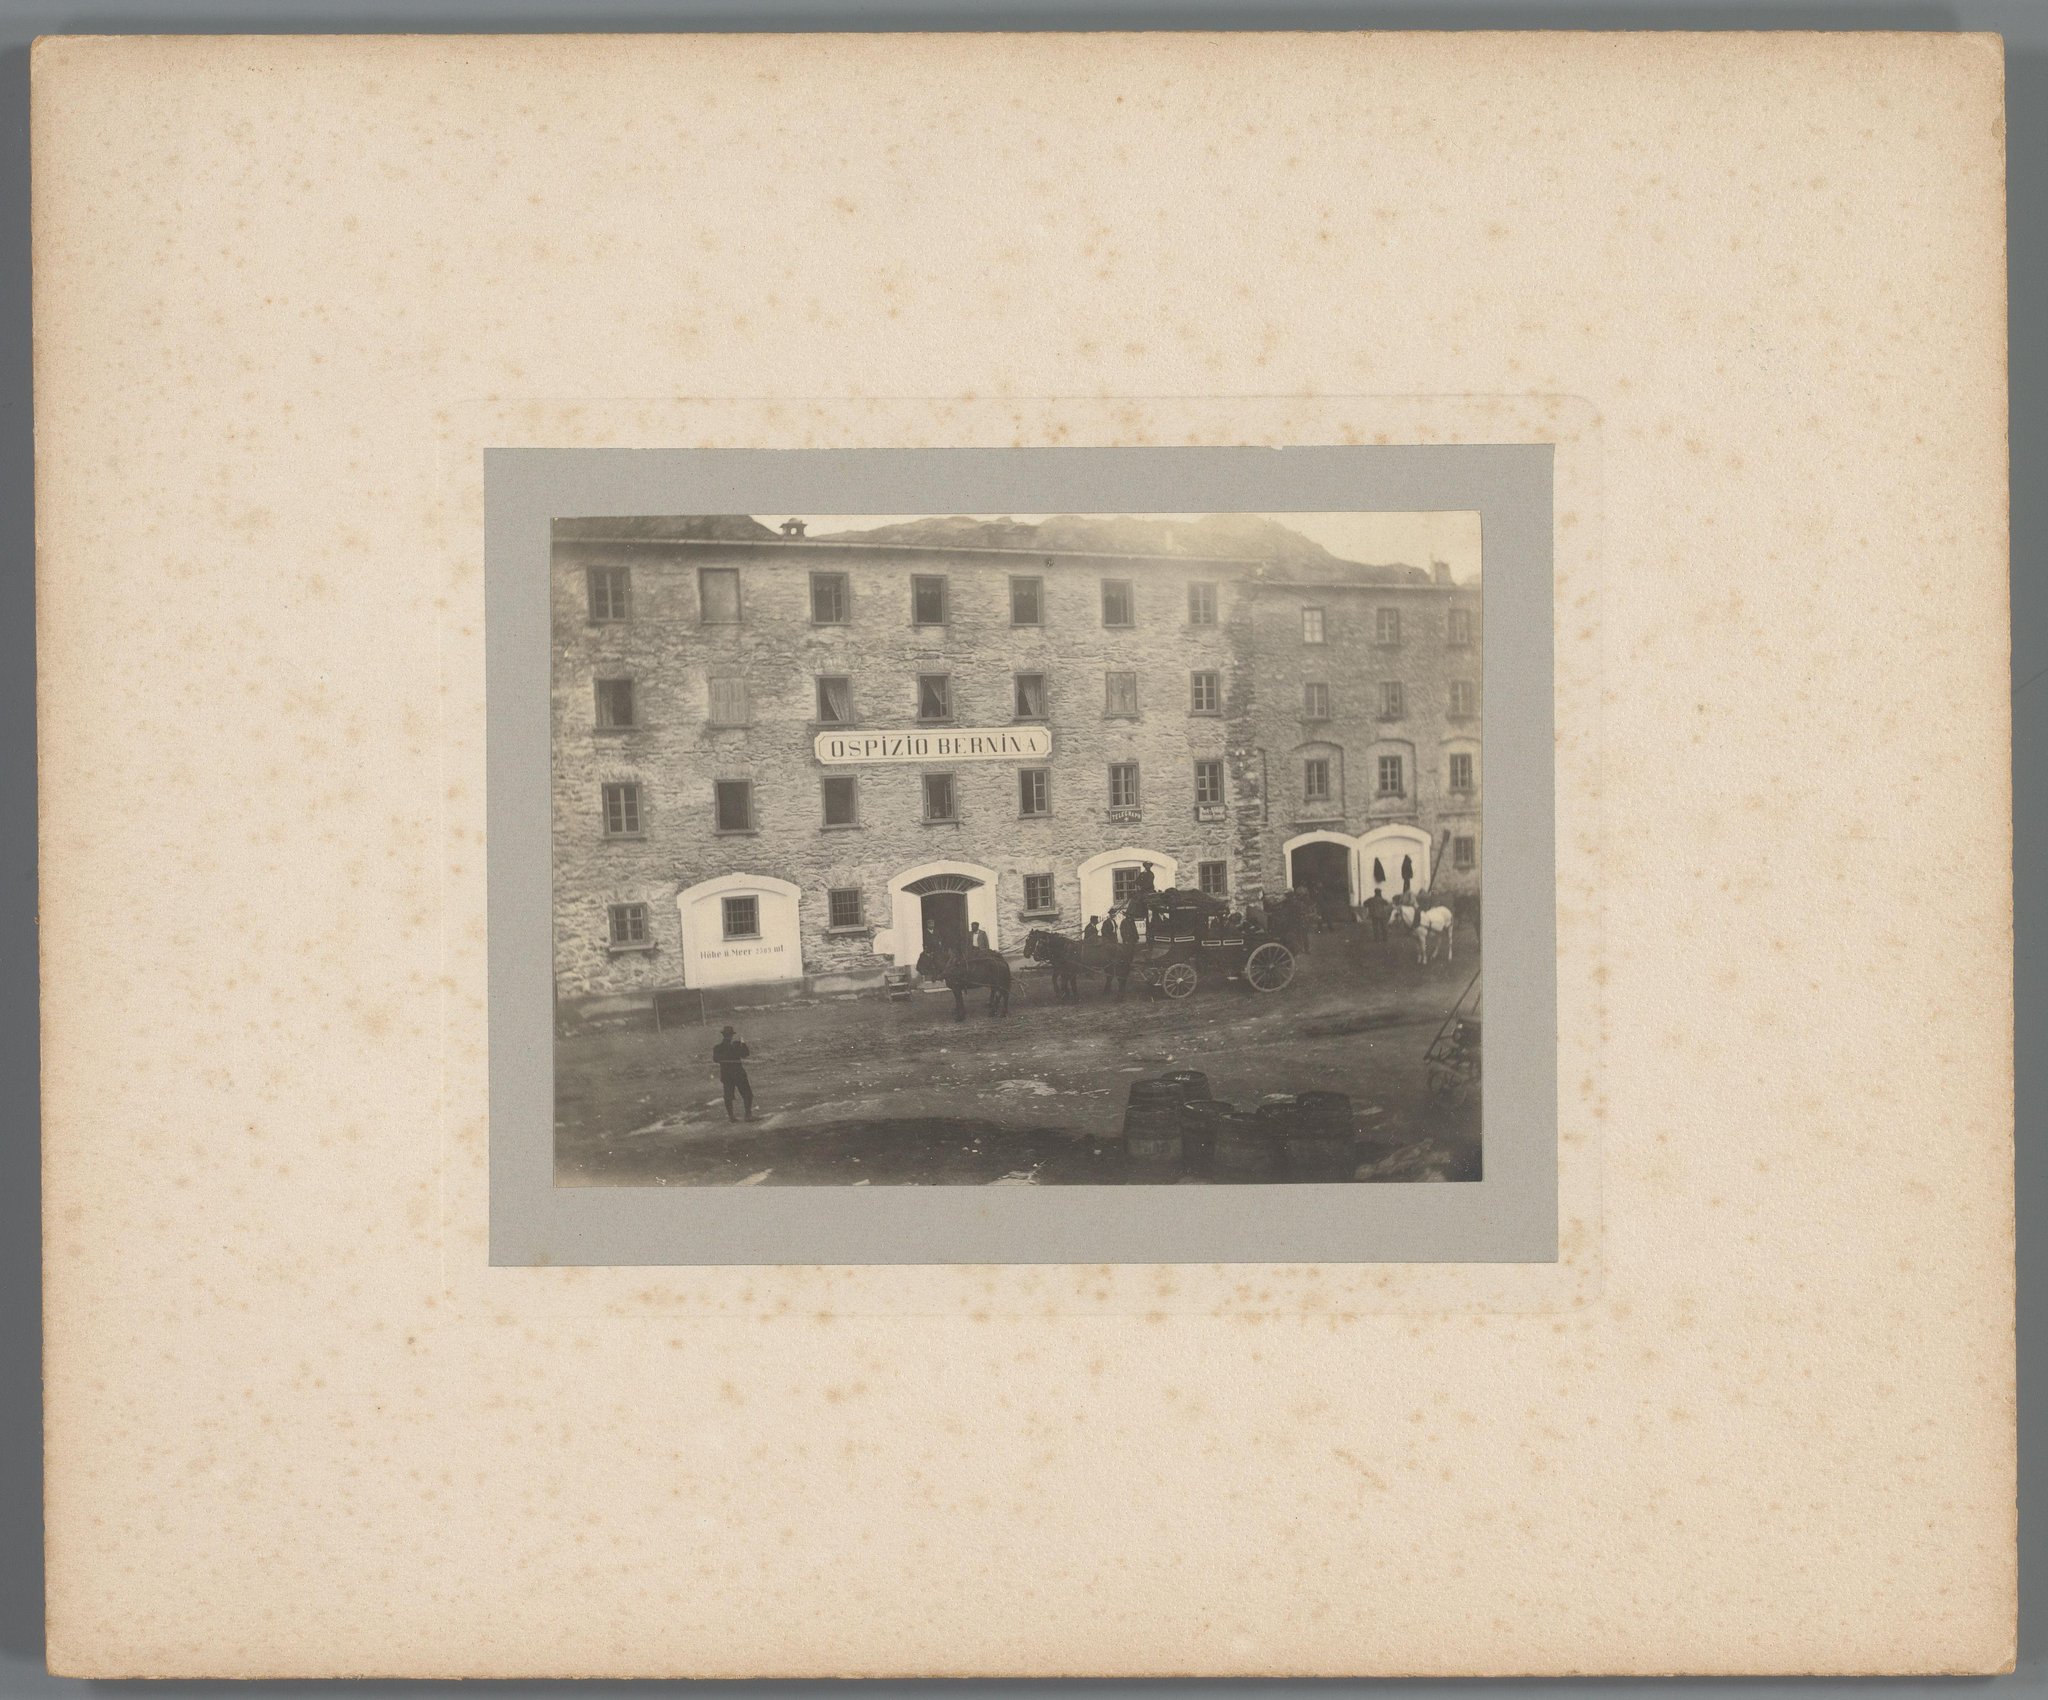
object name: photograph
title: Gezicht op het Hospiz Bernina, Zwitserland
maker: françois buys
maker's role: advocaat, amateurfotograaf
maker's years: 1871-1934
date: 1905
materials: paper, cardboard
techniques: gelatin silver print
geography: bernina pass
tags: four-wheeled vehicle drawn by more than three animals, hotel, hostelry, inn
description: Deze foto maakt deel uit van een groep van 38 foto's.